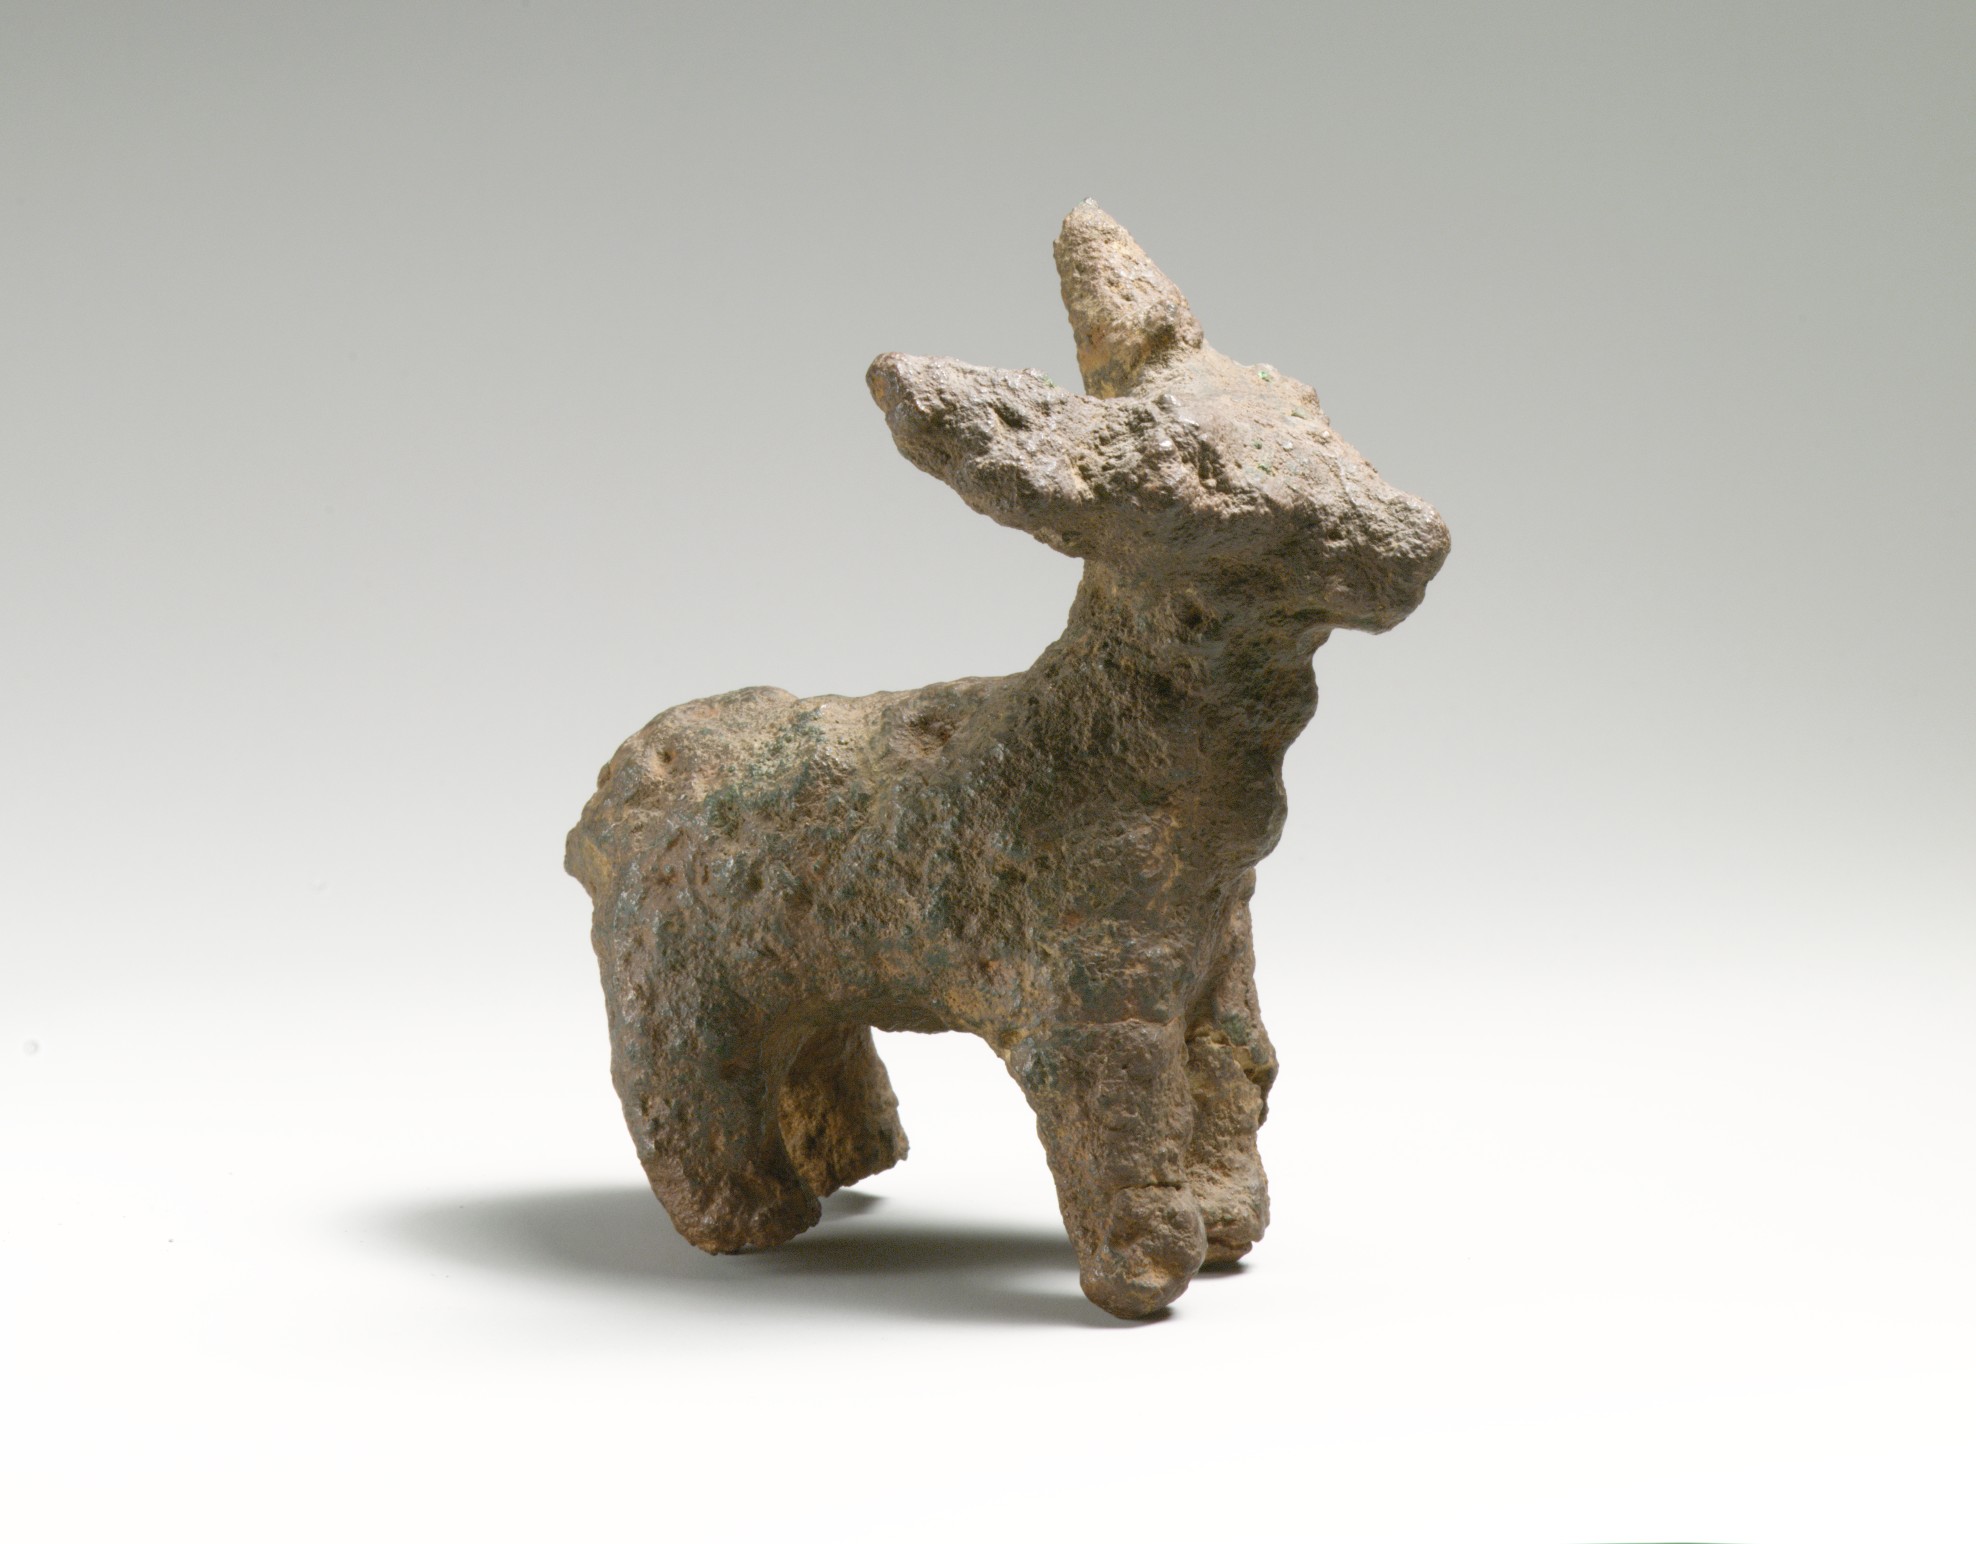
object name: statuette of a deer stag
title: Bronze statuette of a stag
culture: cypriot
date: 900-701 BCE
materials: bronze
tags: deer